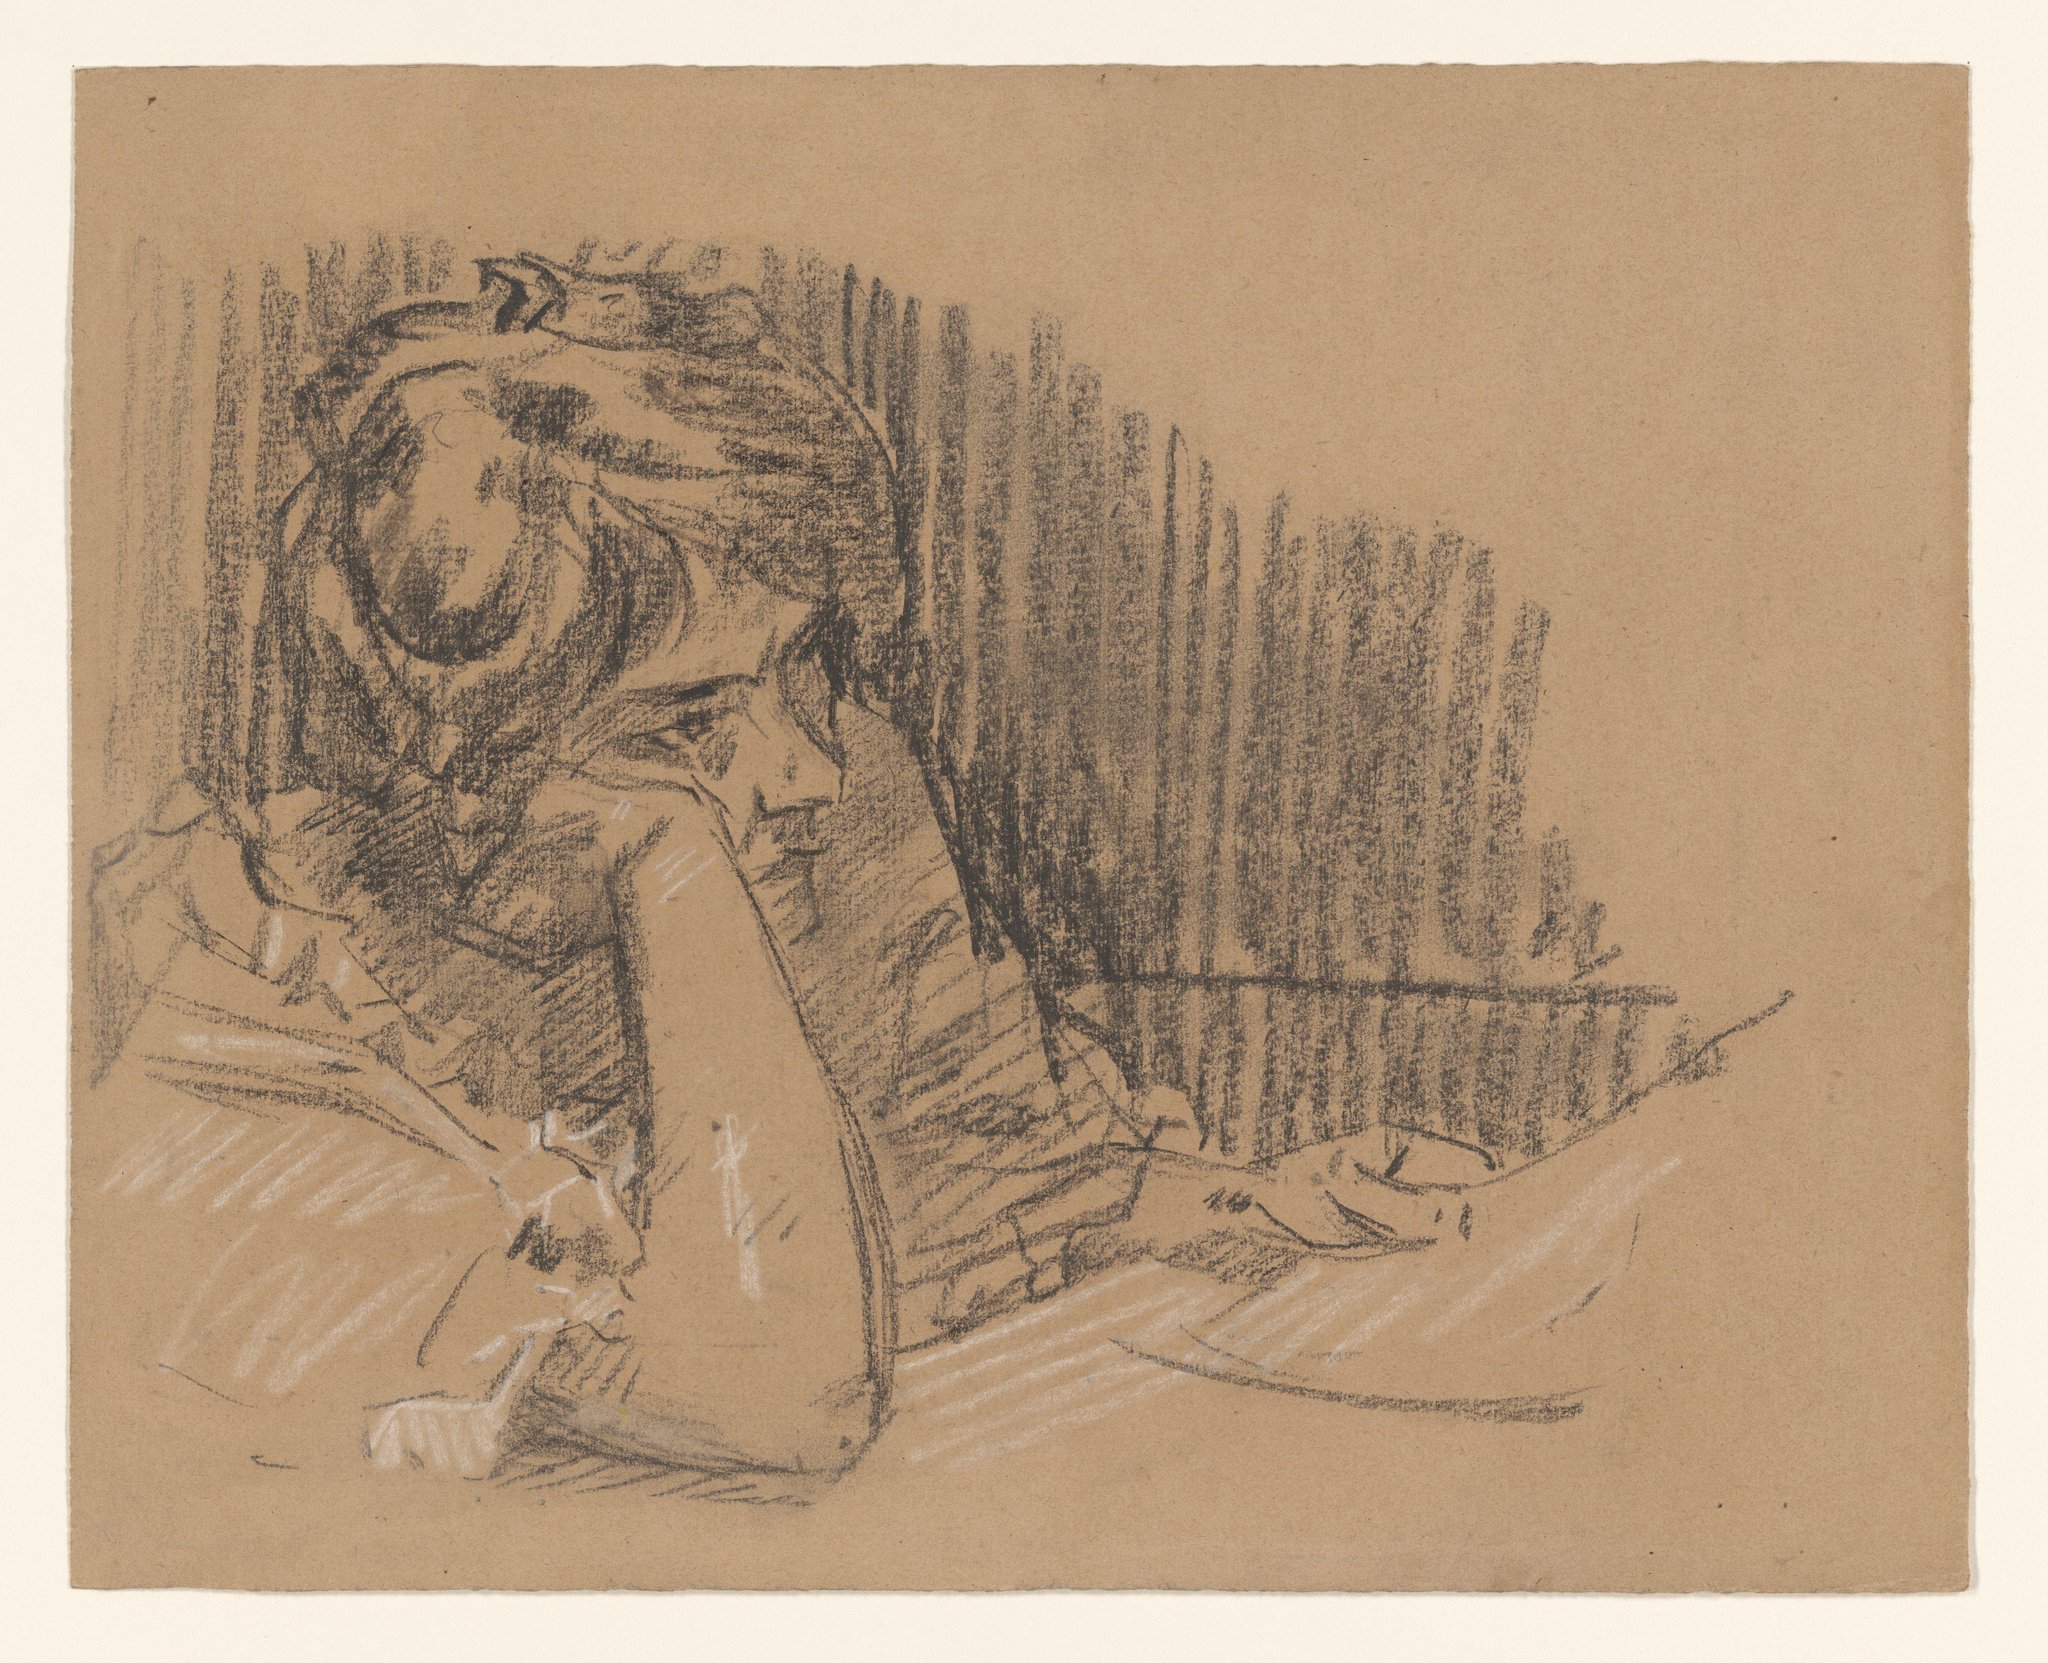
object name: drawing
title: Portret van de vrouw van Wilhelmus Johannes Steenhoff, lezend aan een tafel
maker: wilhelmus johannes steenhoff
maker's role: draughtsman, print maker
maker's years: 1863-1932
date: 1873-1932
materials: chalk, paper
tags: reading, historical persons